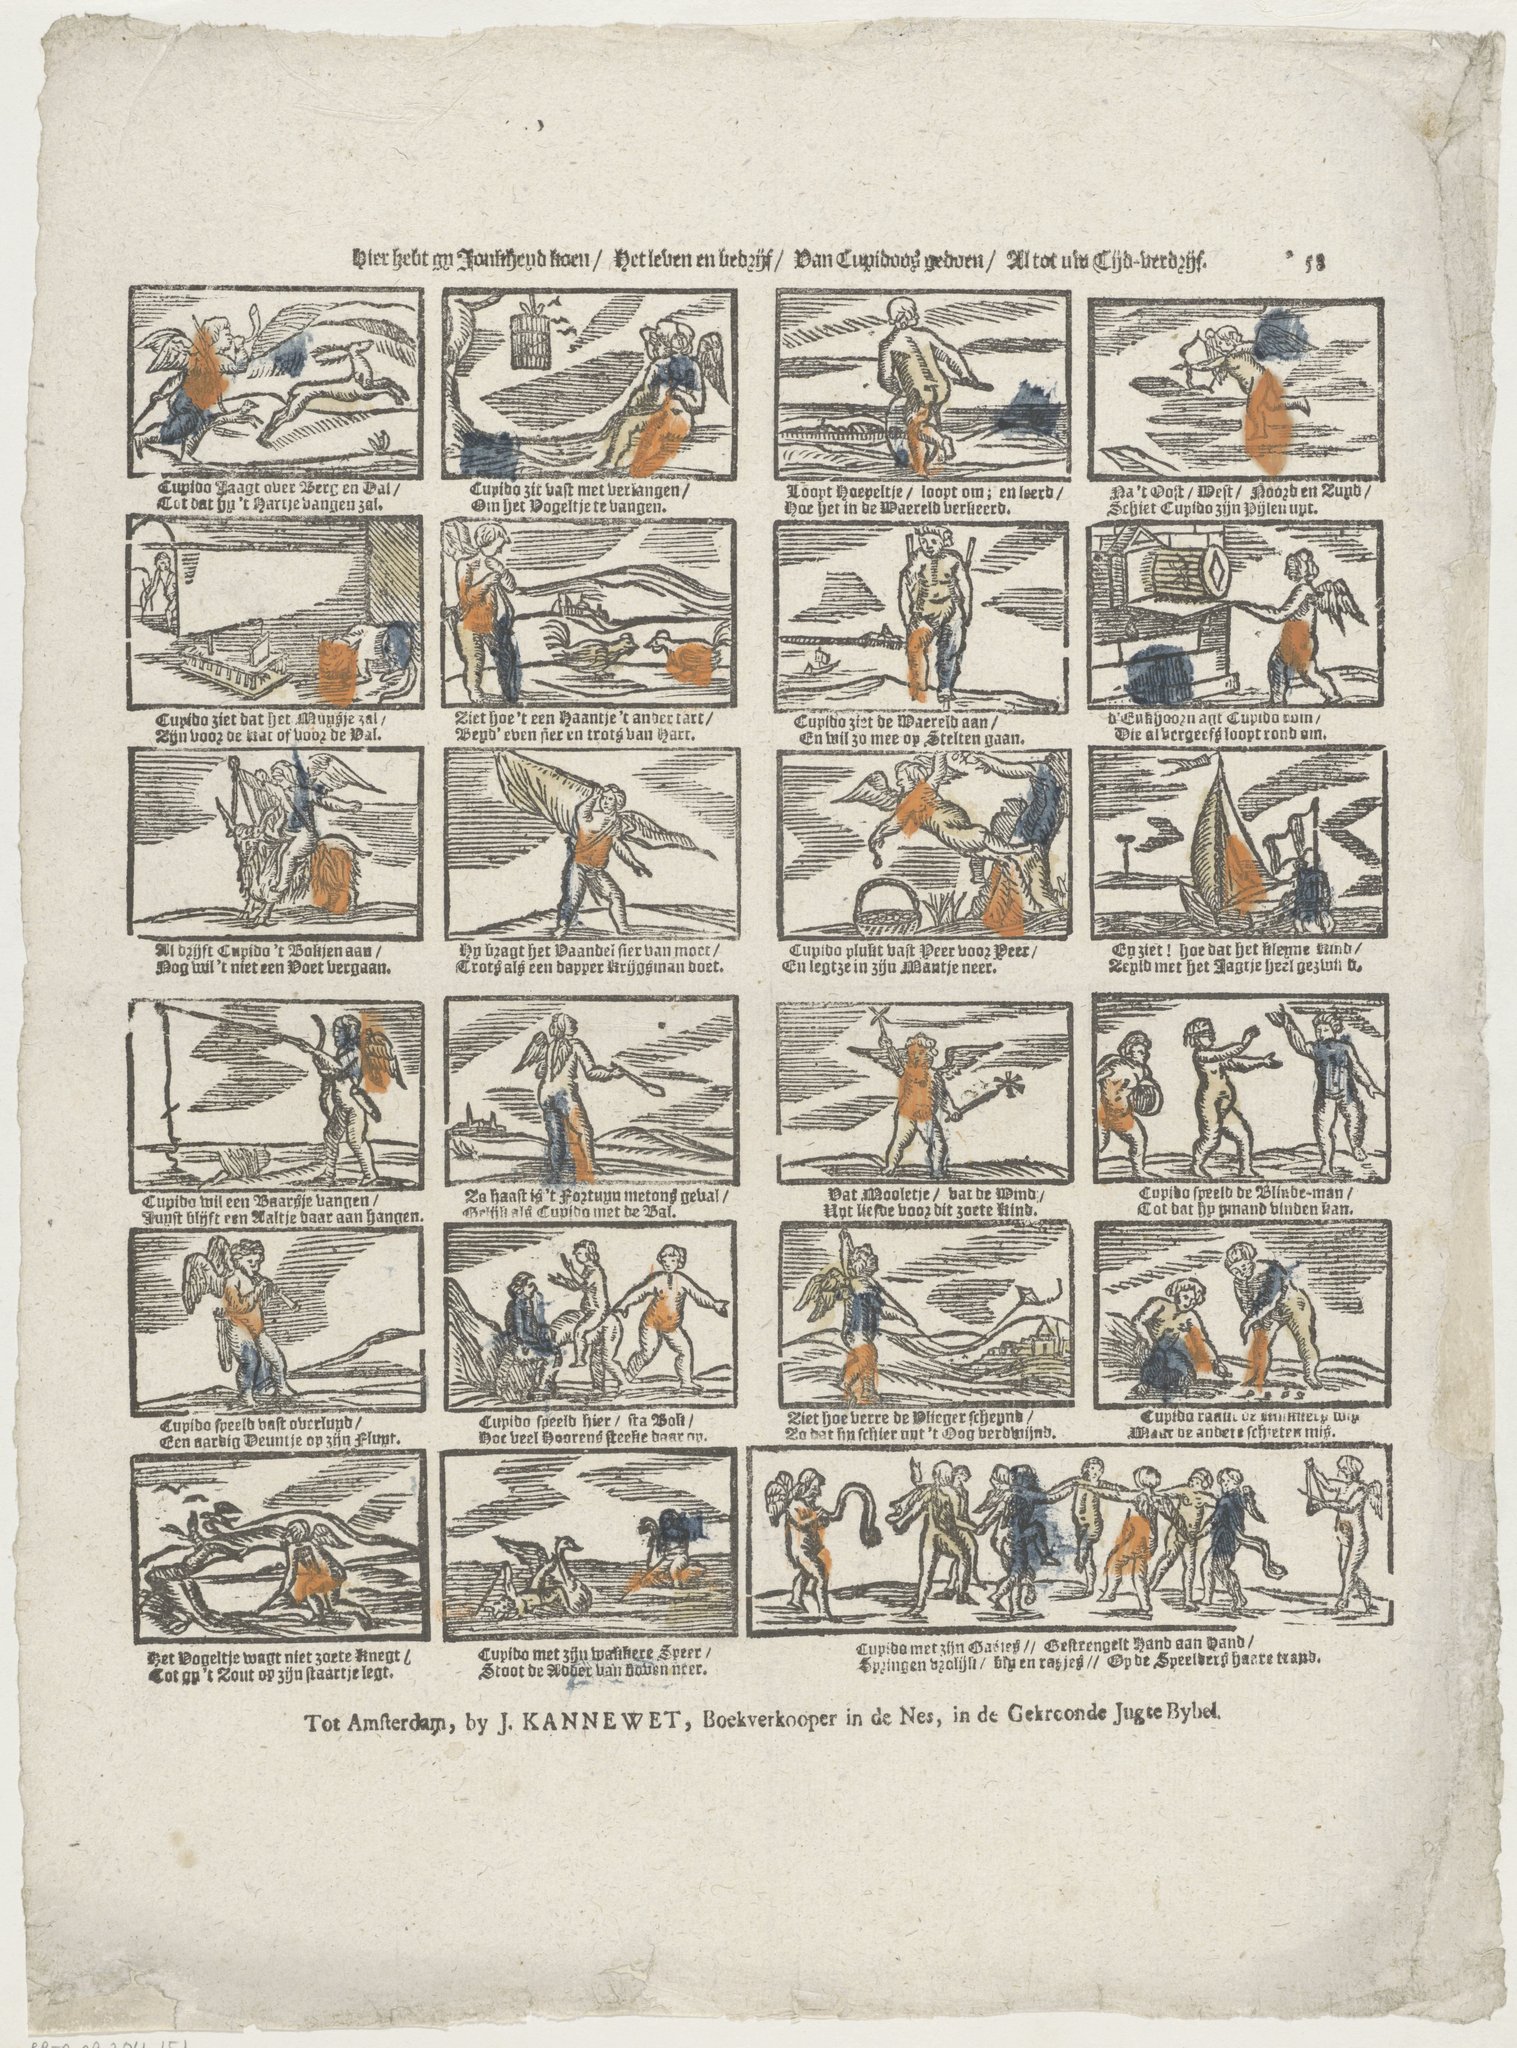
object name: popular print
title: Hier hebt gy jonkheyd koen / Het leven en bedrijf / Van Cupidoos gedoen / Al tot uw tijdverdrijf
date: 1725-1780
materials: paper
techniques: colour, letterpress printing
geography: amsterdam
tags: children's games and plays, cupids: 'amores', 'amoretti', 'putti'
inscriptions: collector's mark: Lugt 2760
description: Blad met 23 voorstellingen van kinderspelen en bezigheden voorgesteld met Cupido's, zoals hoepelen, dansen en vissen. Onder elke afbeelding een tweeregelig vers. Genummerd rechtsboven: *58.